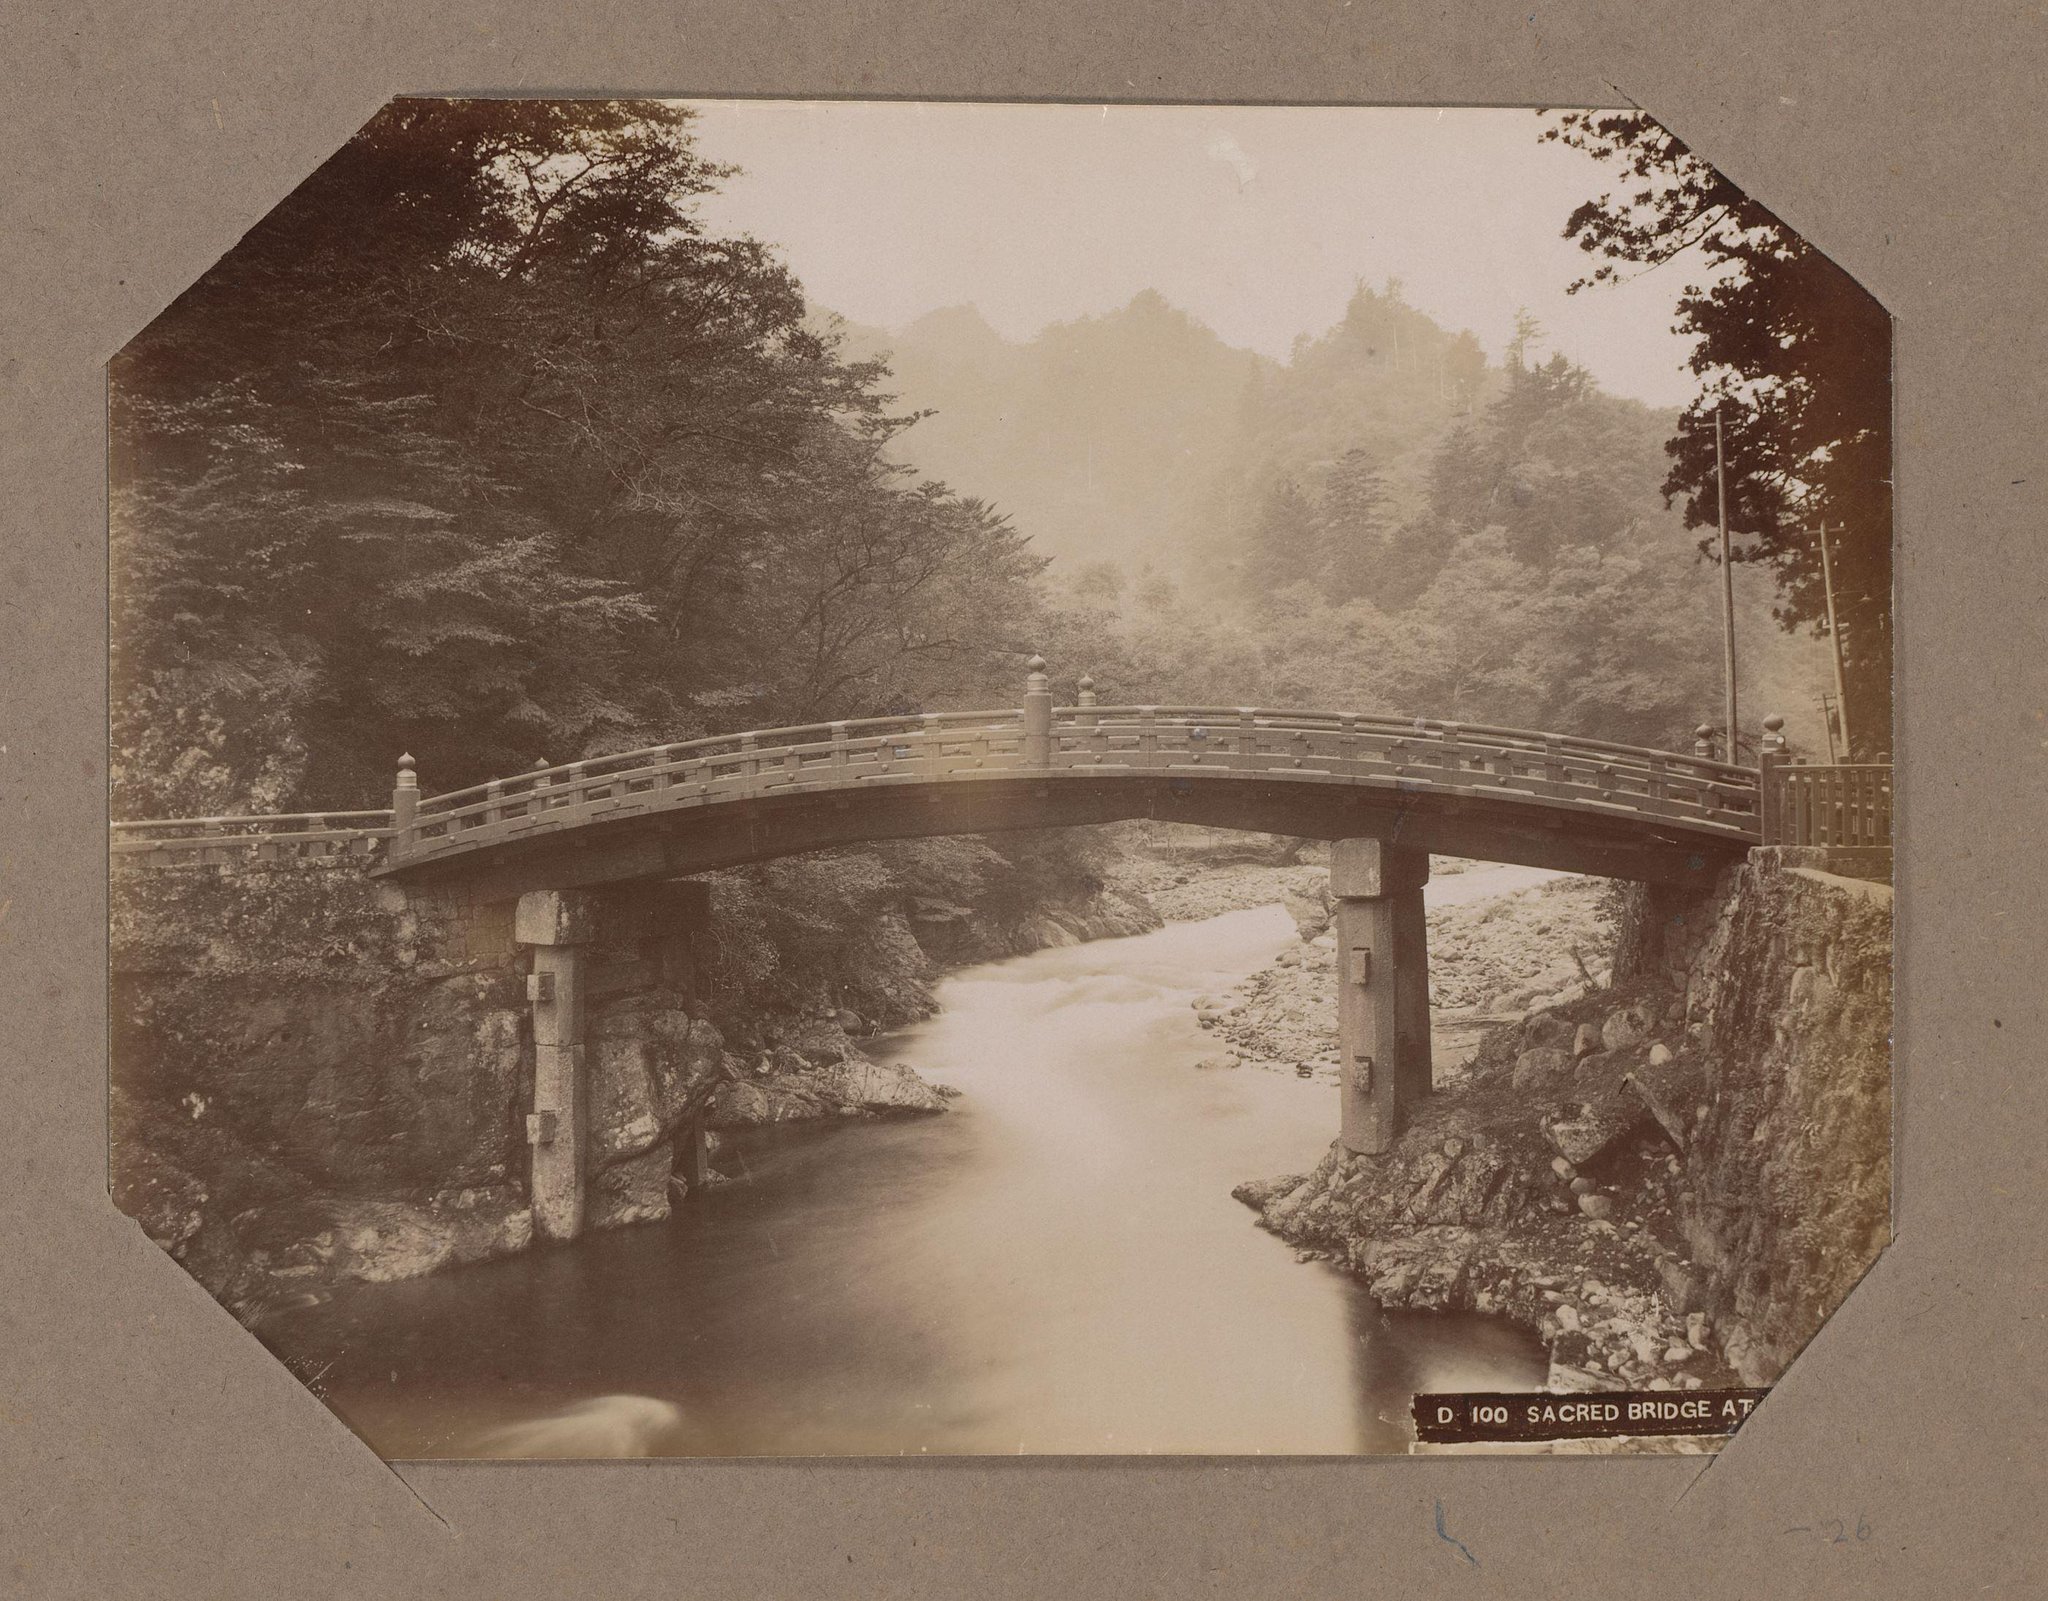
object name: photograph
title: Shinkyo of Heilige brug in Nikko, Japan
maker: Anonymous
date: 1890-1903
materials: paper, photographic support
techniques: albumen print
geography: nikko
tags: landscape with bridge, viaduct or aqueduct, bridge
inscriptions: inscription: ‘D 100 Sacred Bridge at Nikko’